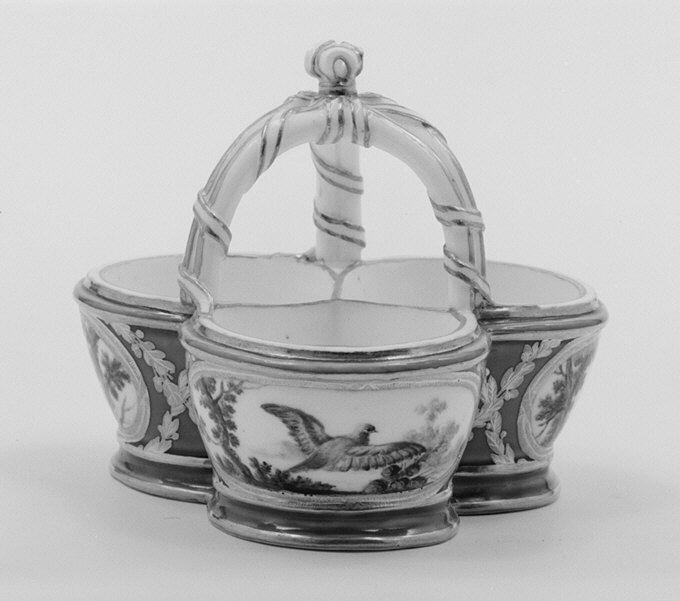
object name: triple salt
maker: sèvres manufactory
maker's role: manufactory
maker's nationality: french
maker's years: 1740-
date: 1770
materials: soft paste porcelain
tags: birds